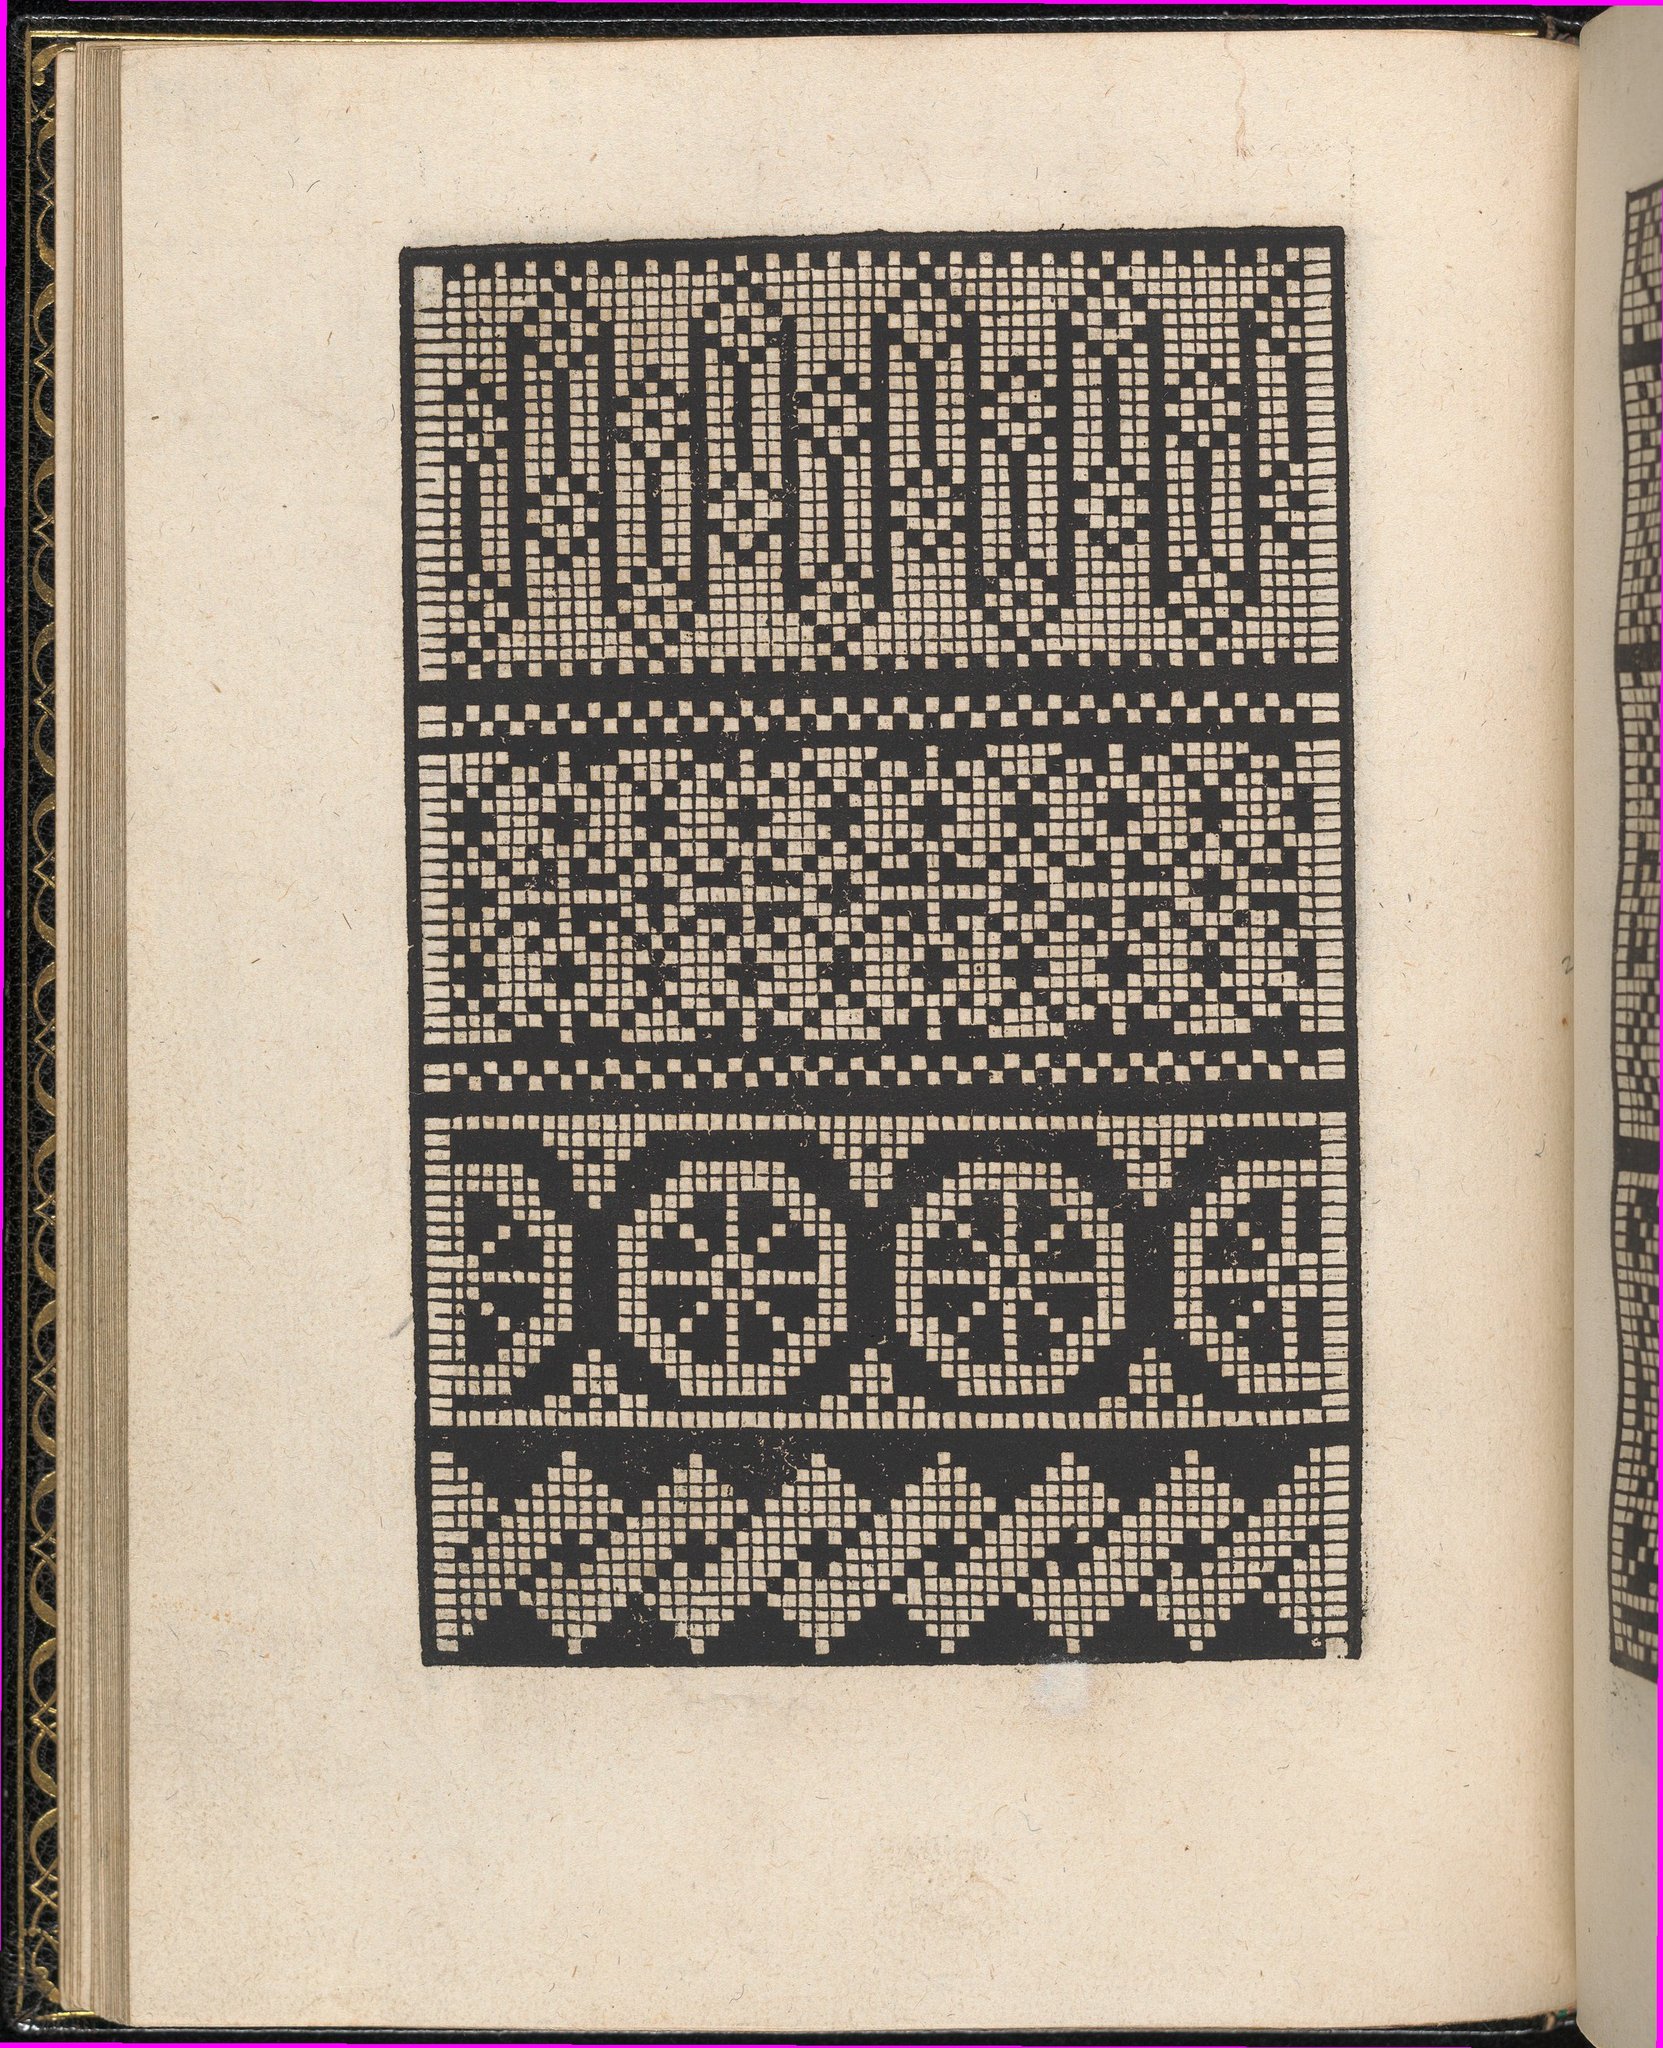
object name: book print ornament architecture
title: Page from Ein new kunstlich Modelbuch...(Page 21v)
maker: peter quentel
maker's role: publisher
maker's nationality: german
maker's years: 1500-1550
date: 1544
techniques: woodcut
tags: ornament